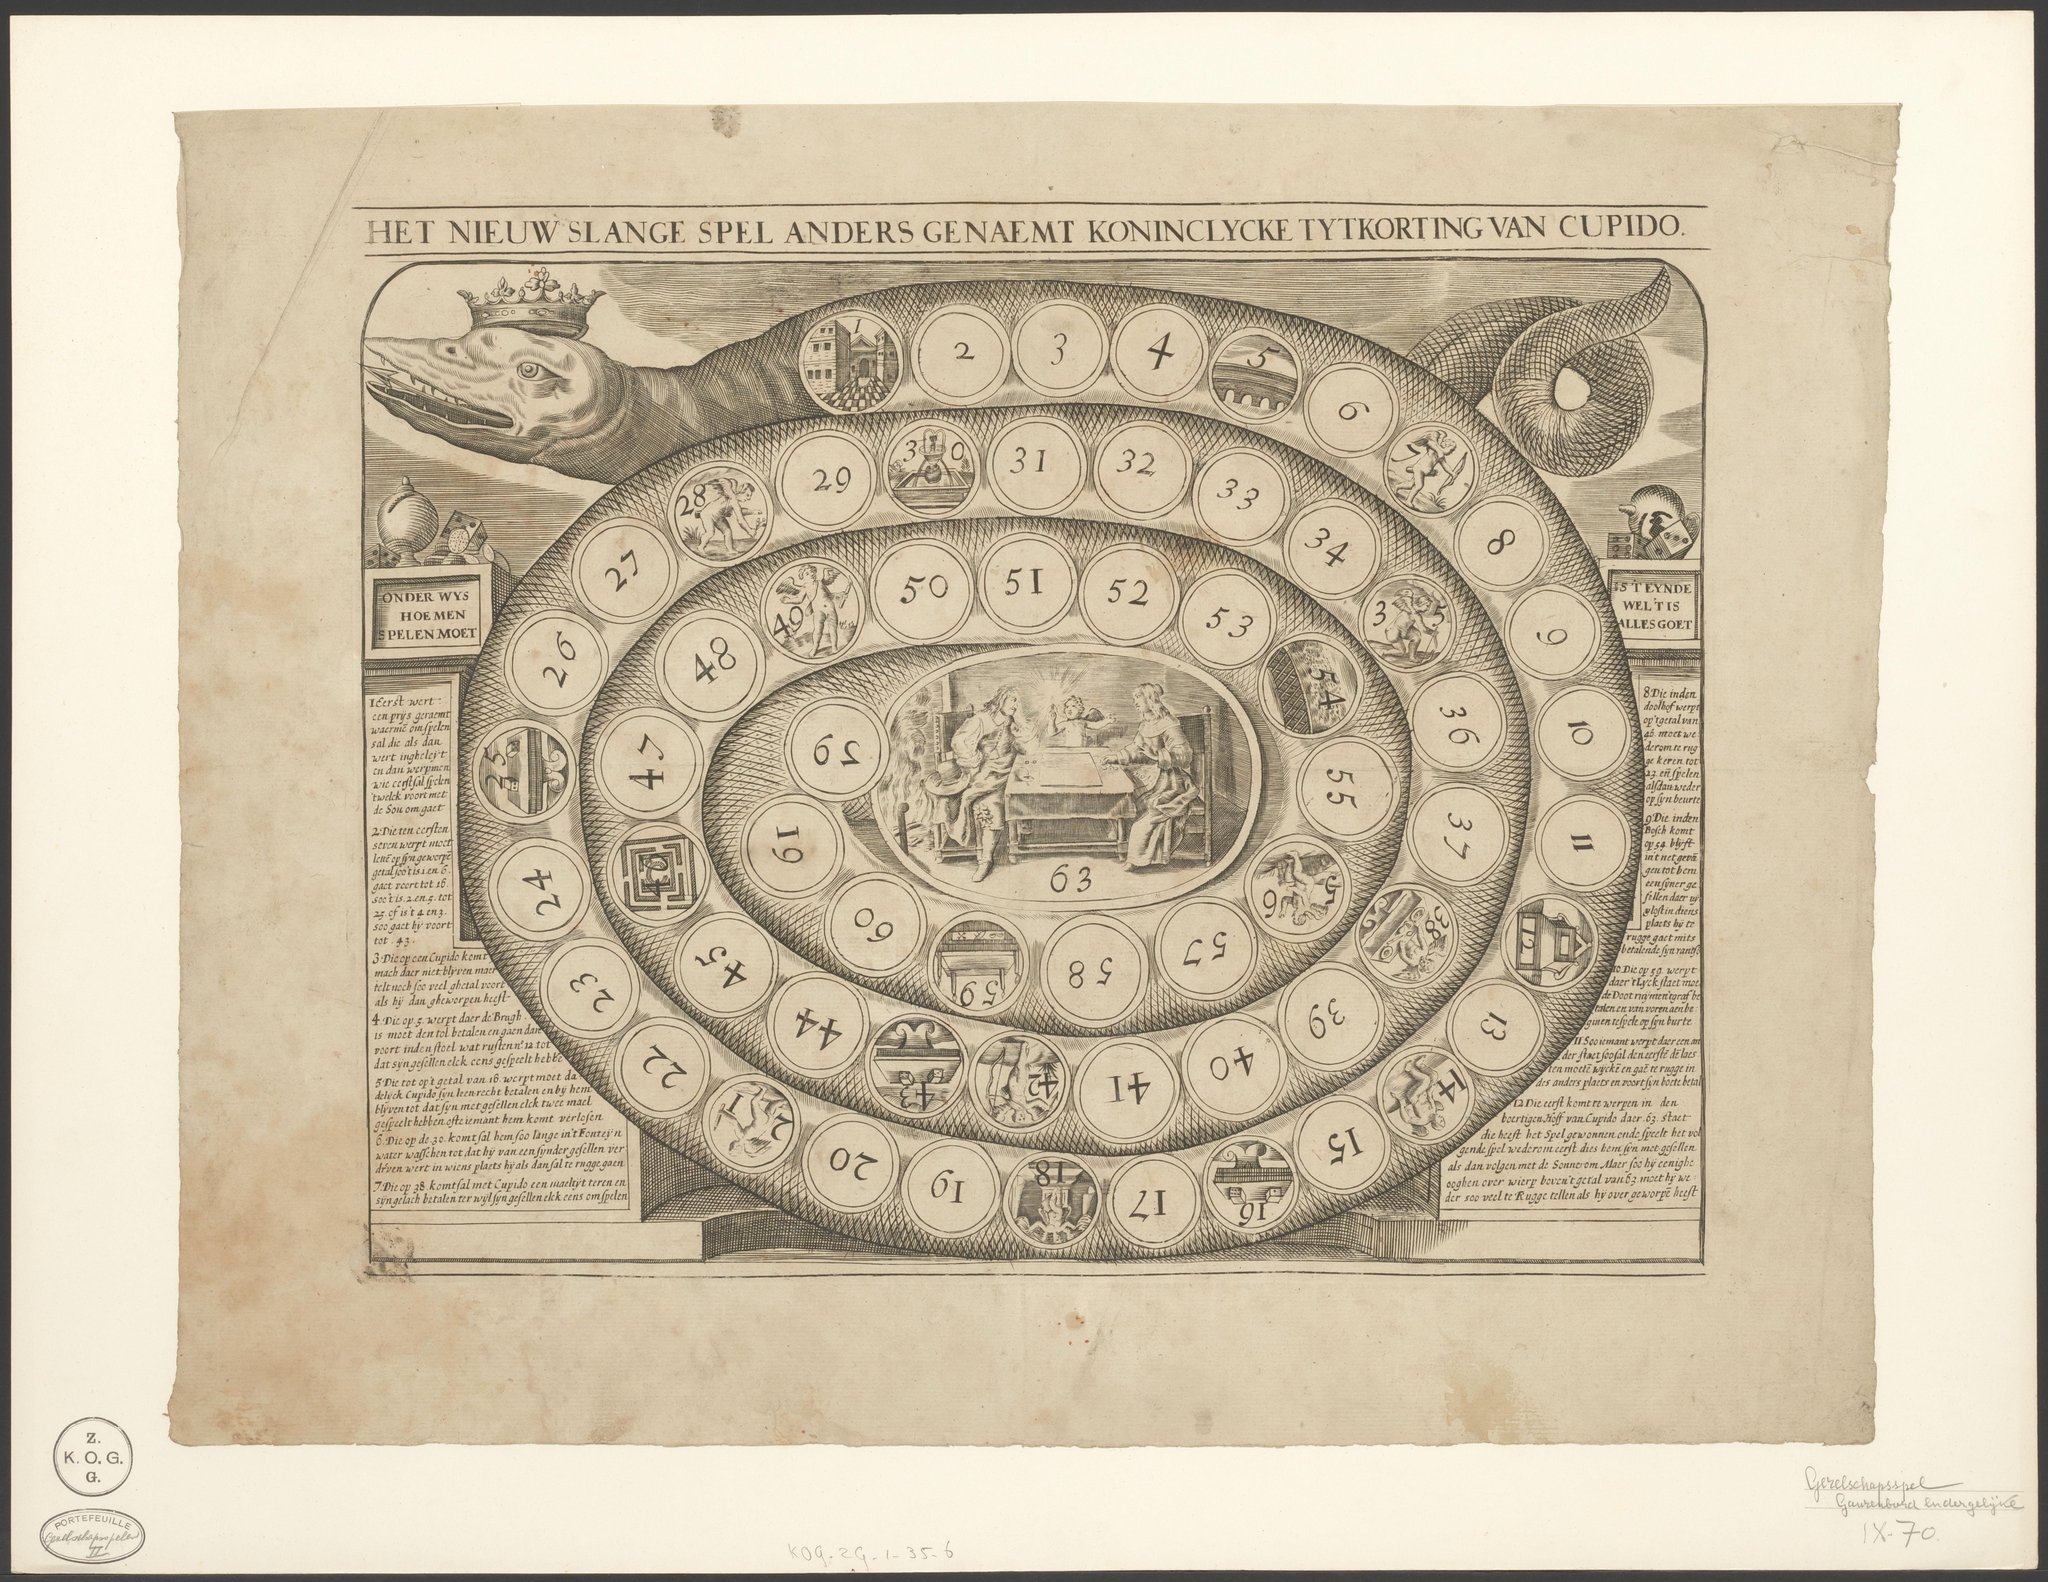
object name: print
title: Slangenspel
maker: Anonymous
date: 1650-1700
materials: paper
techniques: engraving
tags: snakes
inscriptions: stamp, collector's mark: Lugt 1641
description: Bordspel in de vorm van een opgerolde gekroonde slang met vakken genummerd 1-63. In het midden een paar aan een tafel met een bordspel en dobbelstenen. Tussen hen in staat een Cupido. Aan weerszijden de spelregels. Onderwerpsrubrieken binnen de Atlas Zeden en Gewoonten: Zeden en gewoonten in engeren zin, Spel en vermaak, Gezelschapsspel II, Ganzenbord en dergelijke.